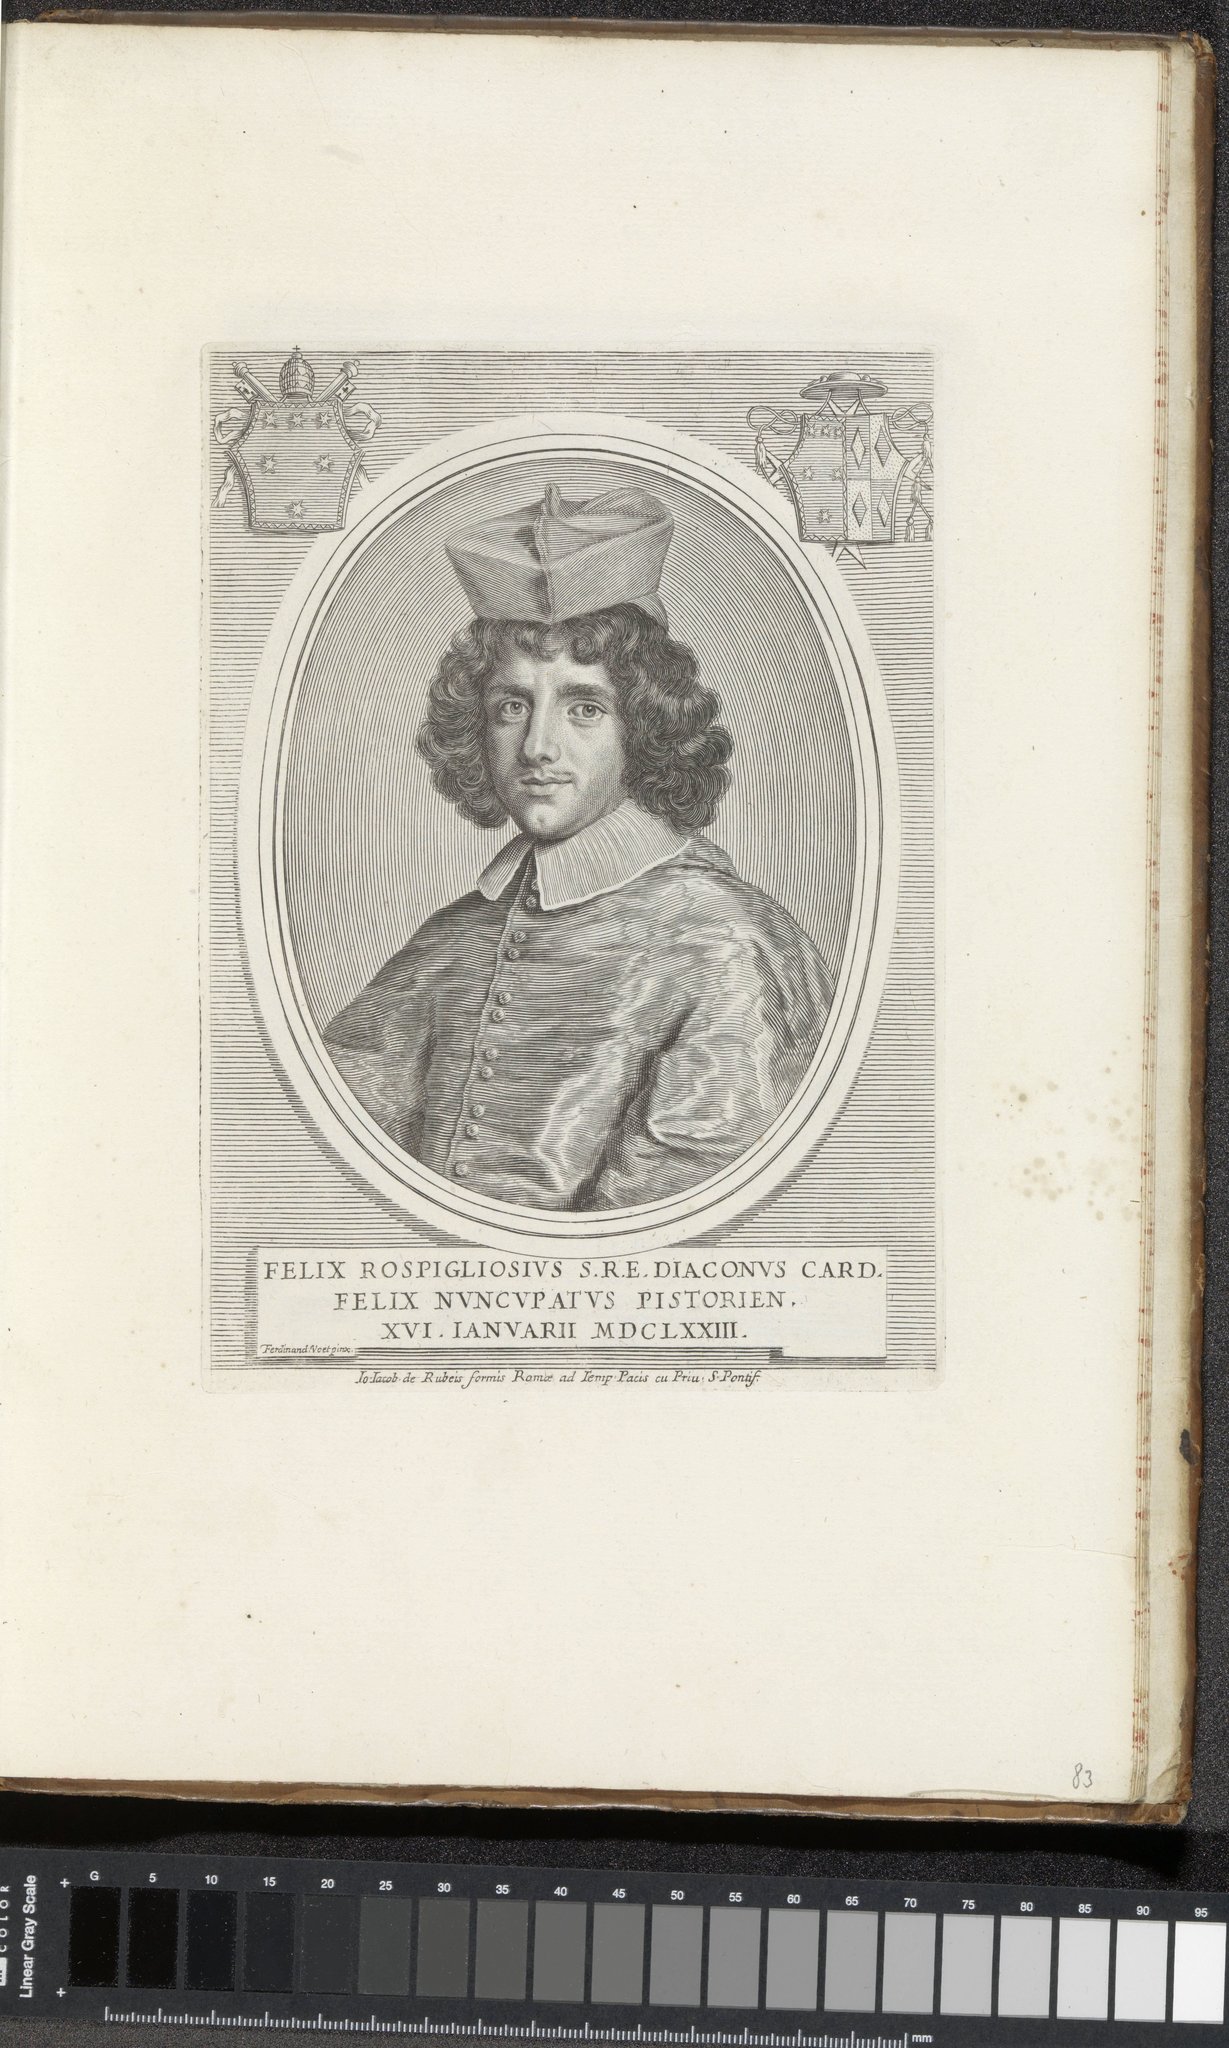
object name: print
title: Portret van kardinaal Felice Rospigliosi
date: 1673-1691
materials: paper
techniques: engraving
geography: rome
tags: rome, cardinal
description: Portret van kardinaal Felice Rospigliosi. Linksboven het wapen van paus Clemens X en rechtsboven het wapen van de kardinaal. Onderaan een onderschrift in het Latijn. De prent maakt deel uit van een album.